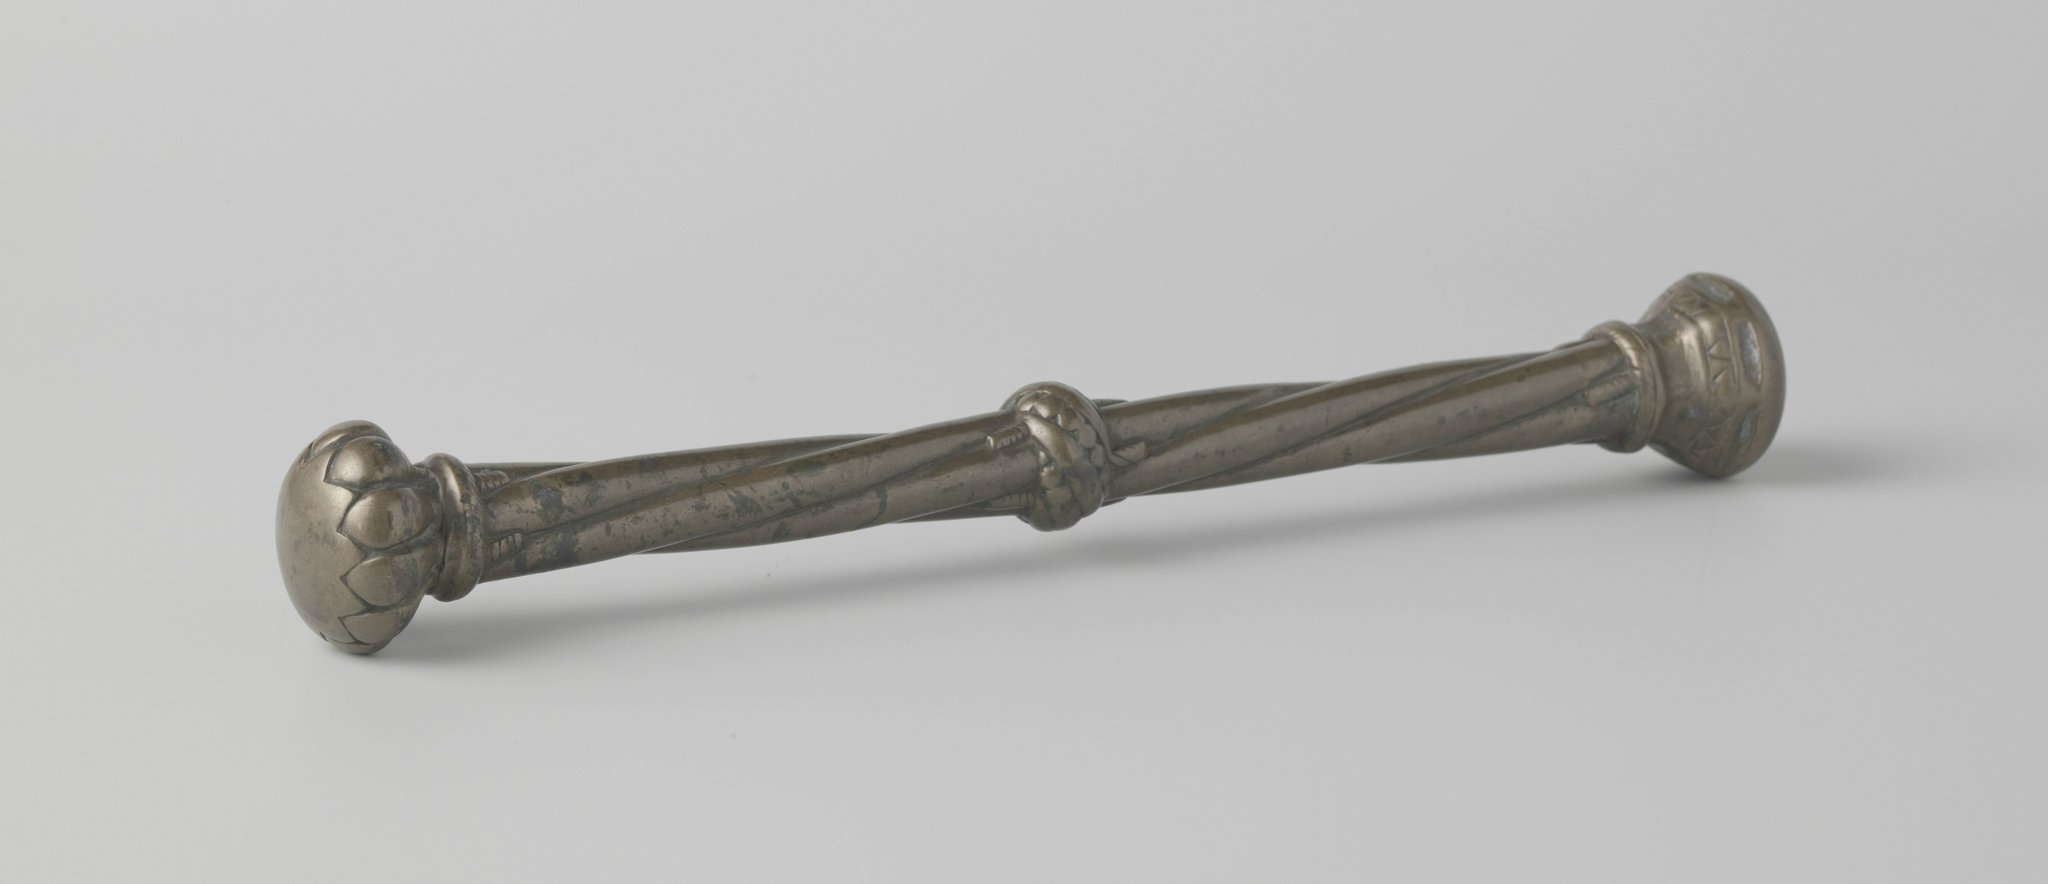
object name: beater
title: Stamper waarvan de steel uit vier getordeerde ribben is opgebouwd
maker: albert hachmann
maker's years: 1520-1565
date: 1537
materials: bronze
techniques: casting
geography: cleves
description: Mortar and pestle with inscription: 'jhesus maria anno domini MCCCCXXXVII' Bronze. Cleves, 1537, Albert Hachman (?).